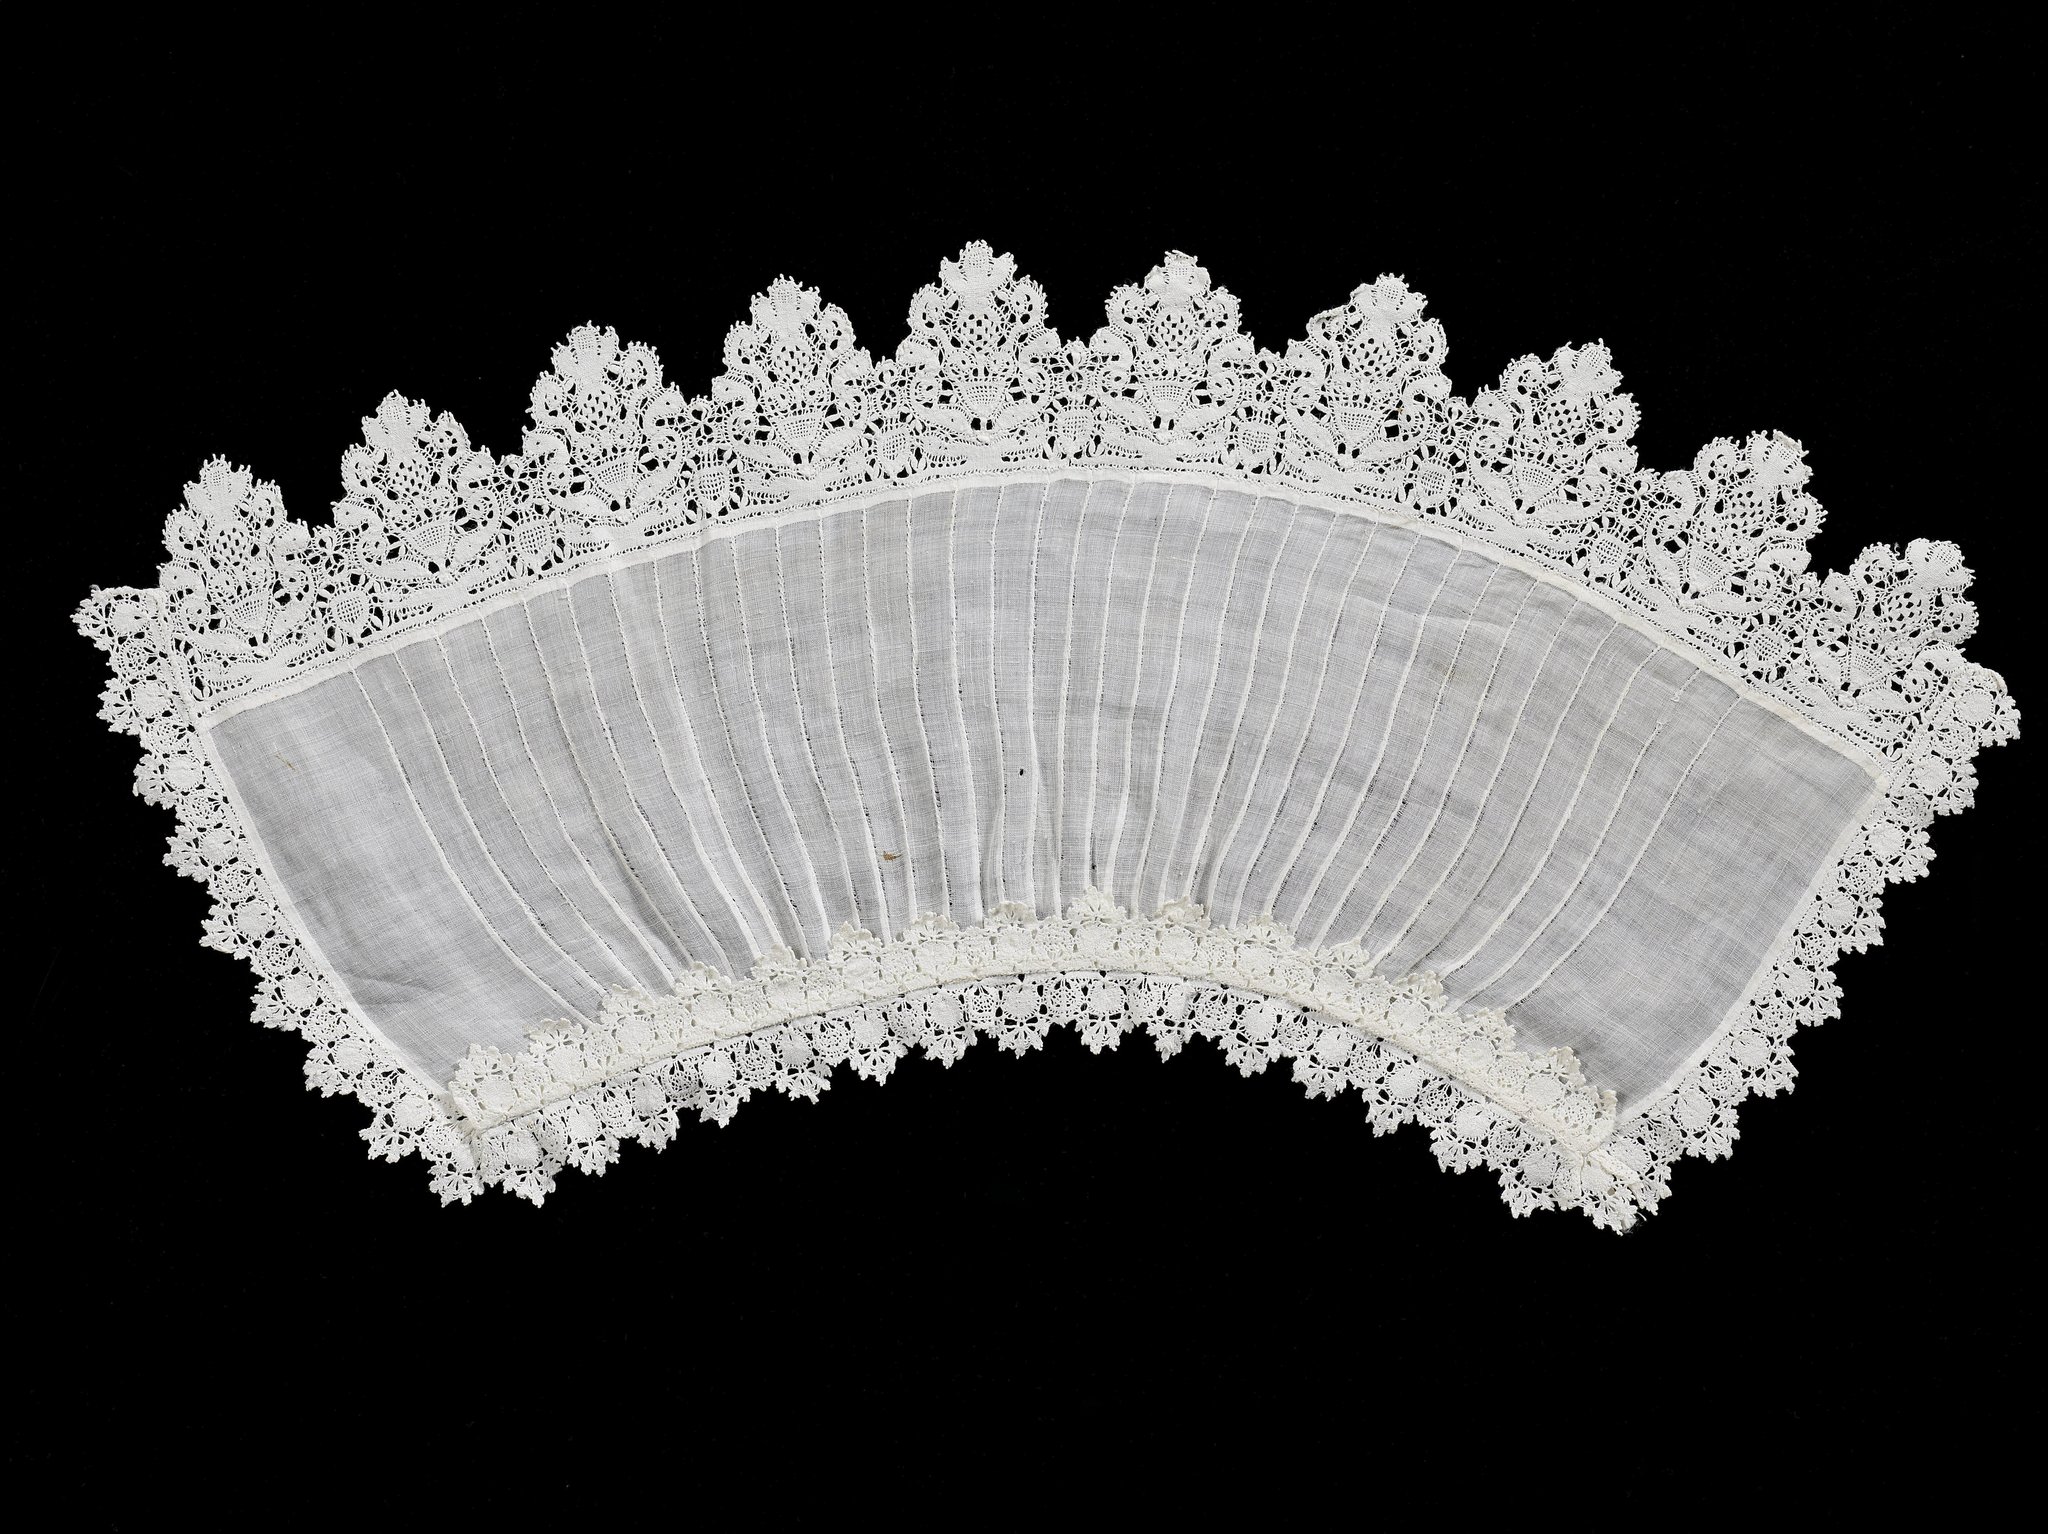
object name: cuff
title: Manchet van linnen batist en rondom afgezet met schulpen van kloskant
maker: Anonymous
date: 1635-1640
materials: textile, linen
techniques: lace, weave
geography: netherlands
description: Manchet, linnen, kloskant Manchet: Noordelijke Nederlanden Kant: Zuidelijke Nederlanden, 1630-1640 Inv. BK-1978-464